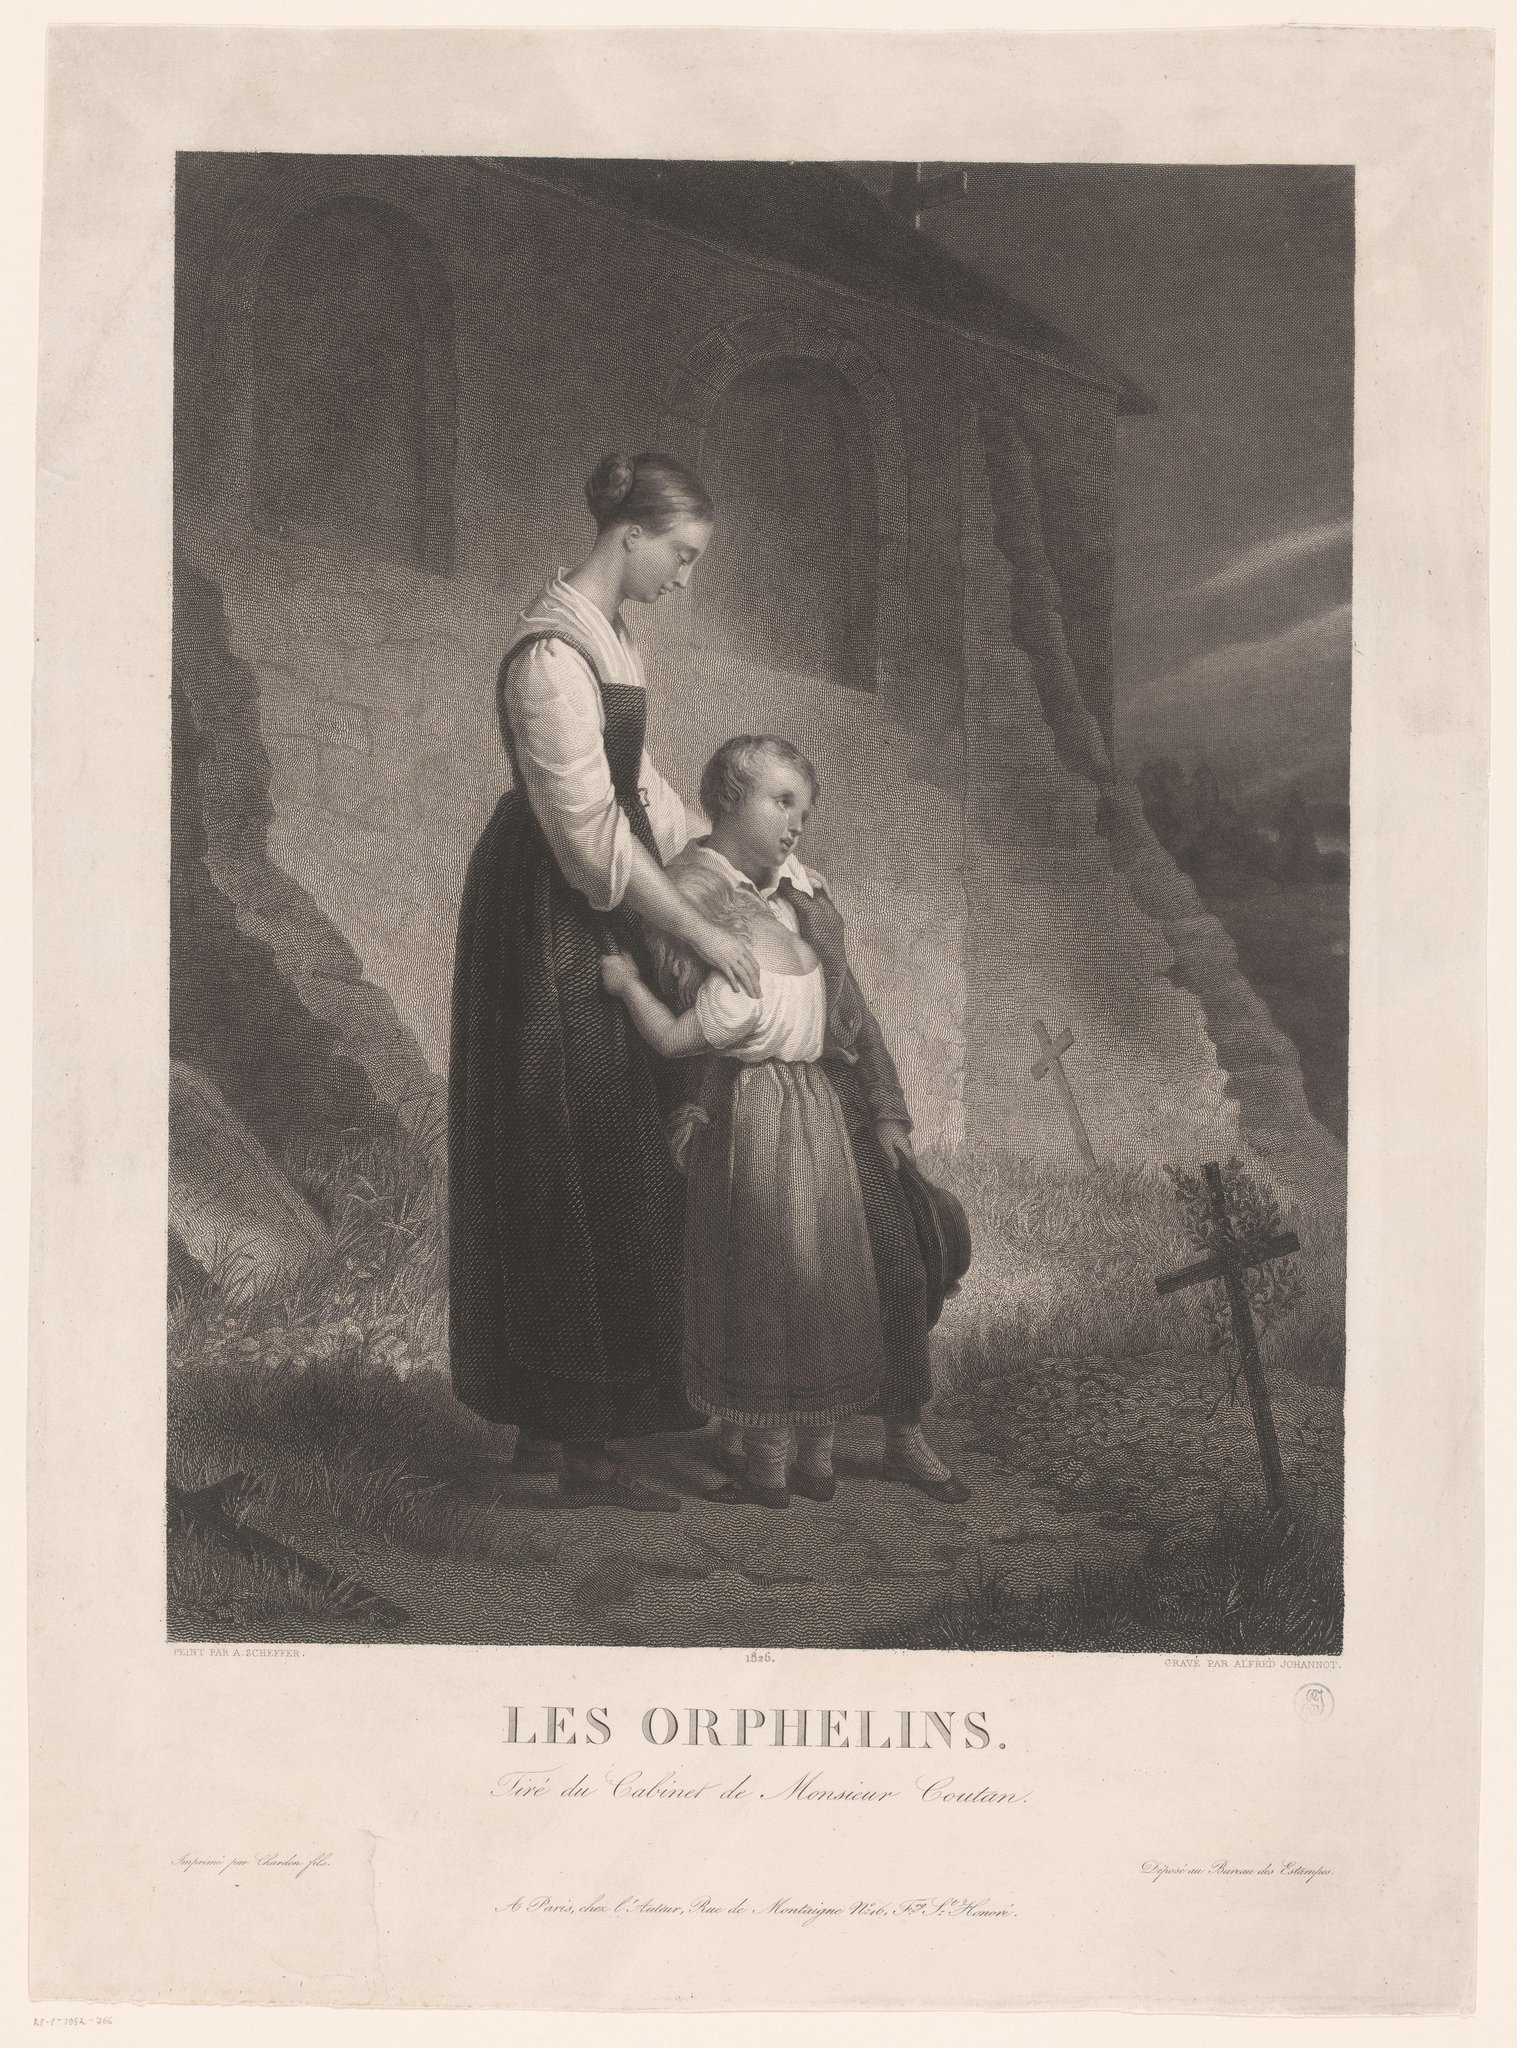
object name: print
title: Weeskinderen bij het graf van hun ouders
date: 1826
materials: paper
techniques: engraving, etching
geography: france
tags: church (exterior), grave, tomb, orphans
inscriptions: : ‘Déposé au Bureau des Estampes.’, collector's mark: Lugt 2228, collector's mark: Lugt 2356